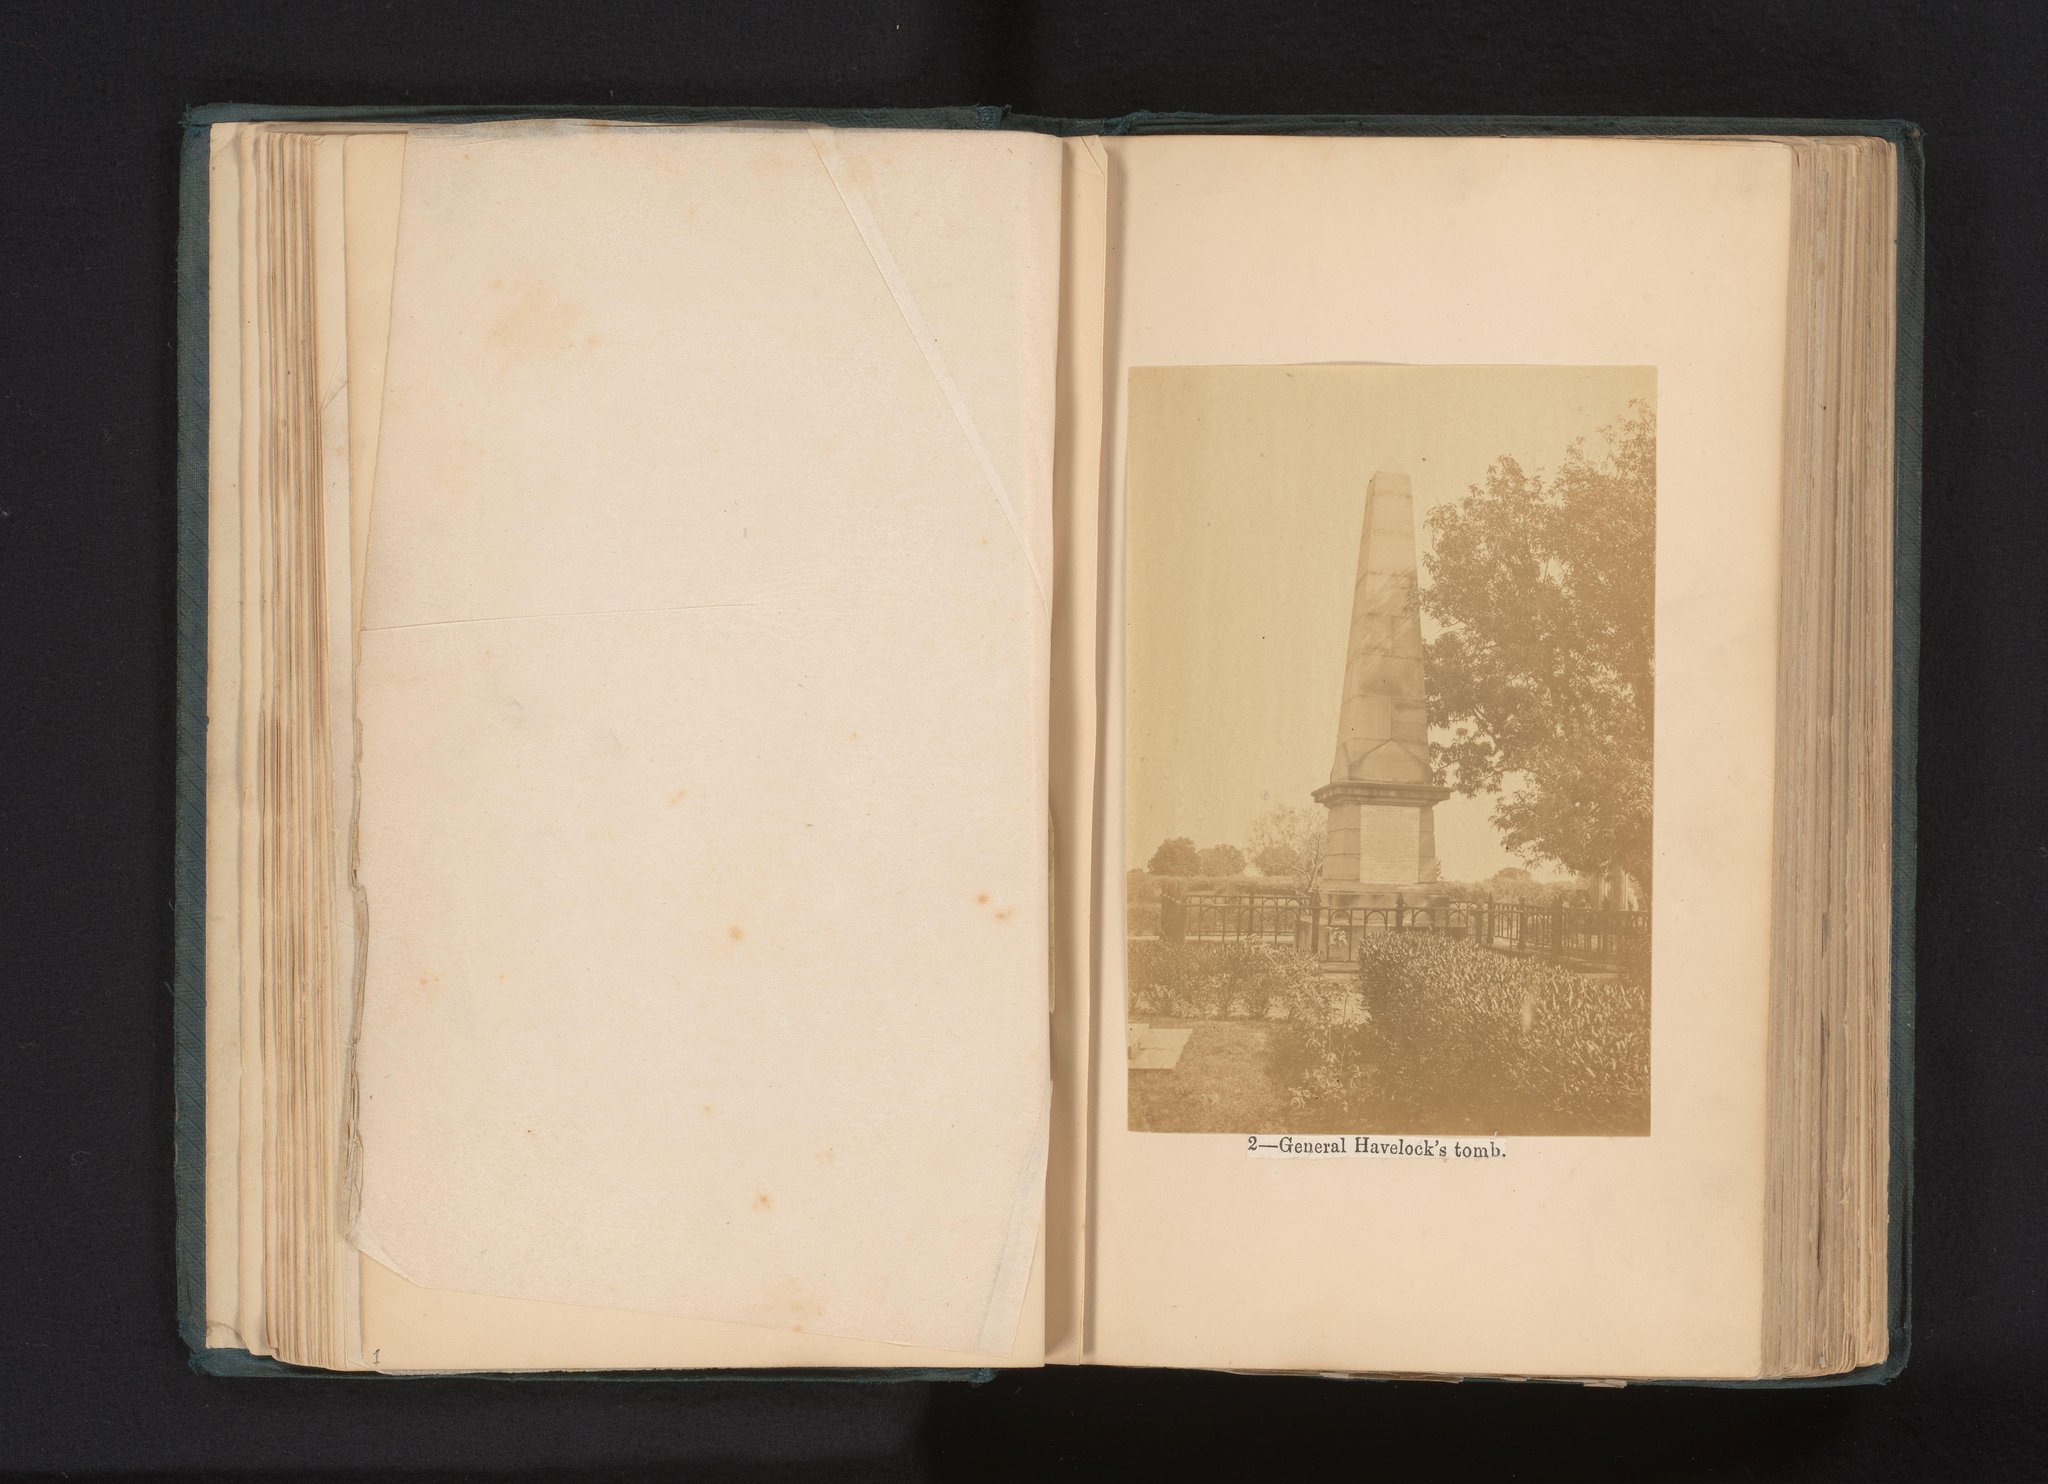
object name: photograph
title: Monument voor Henry Havelock in Lucknow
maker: darogha ubbas alli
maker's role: fotograaf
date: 1862-1872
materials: photographic support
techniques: albumen print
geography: lucknow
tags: grave, tomb, needle, obelisk (marking grave)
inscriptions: number: ‘2’